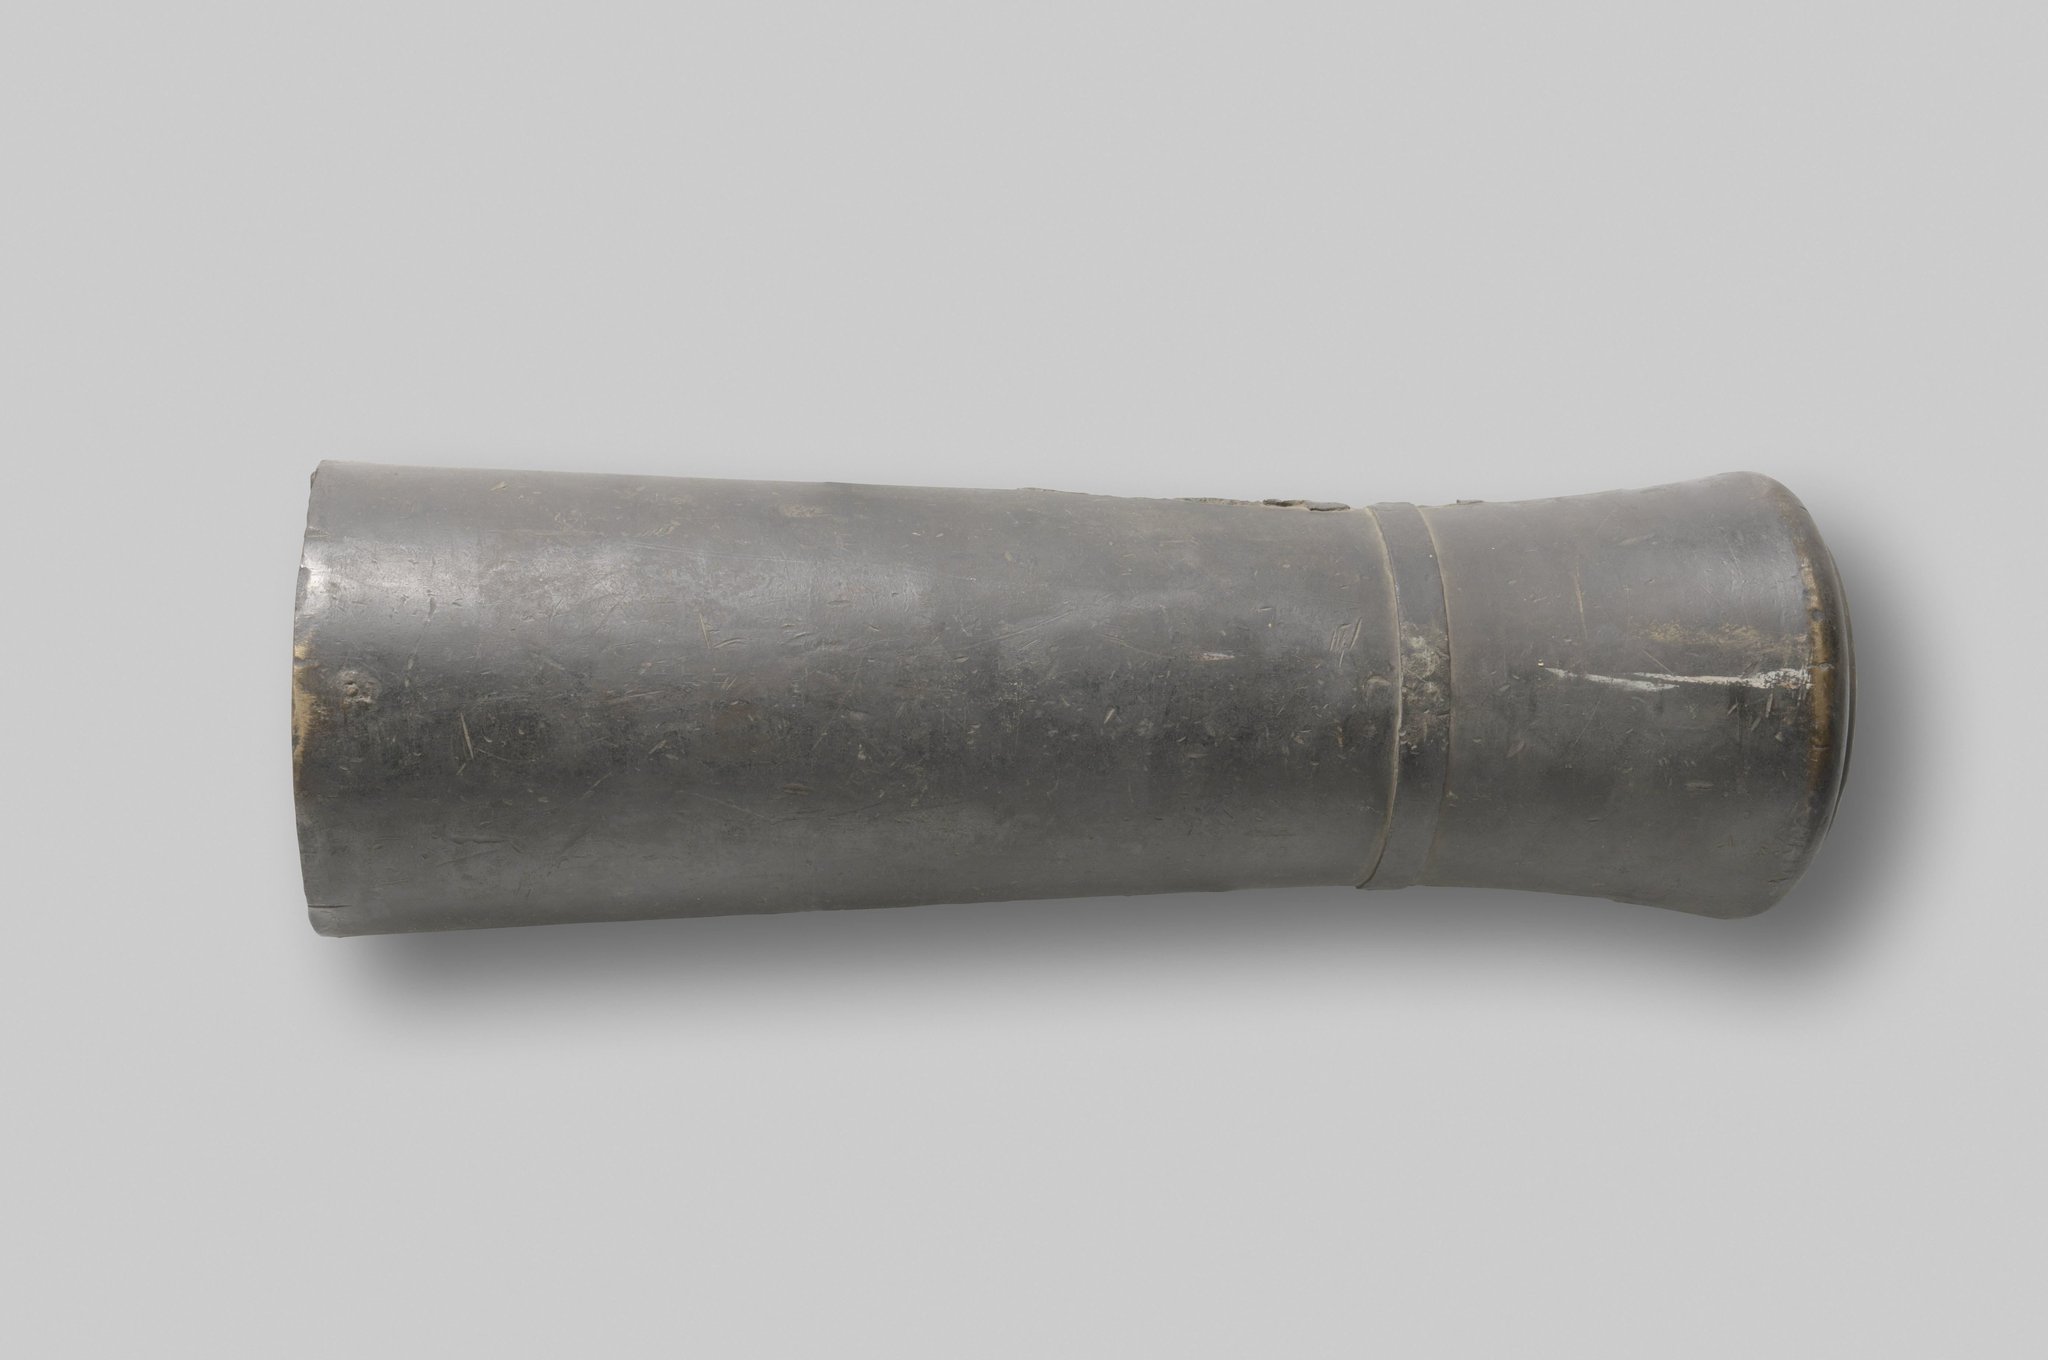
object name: cannon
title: Bronzen voorlaadkanon, linkerdeel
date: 1845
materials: bronze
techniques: casting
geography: the hague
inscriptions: signature: ‘MARITZ ET FIL...’, inscription: ‘C II / N° 79 / NP 339’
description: Bronzen voorlaadkanon van 339 NP in drie stukken. Opschrift: MARITZ ET FILEC HAGAE, 1845. Volgegoten en in 3 stukken gesneden.